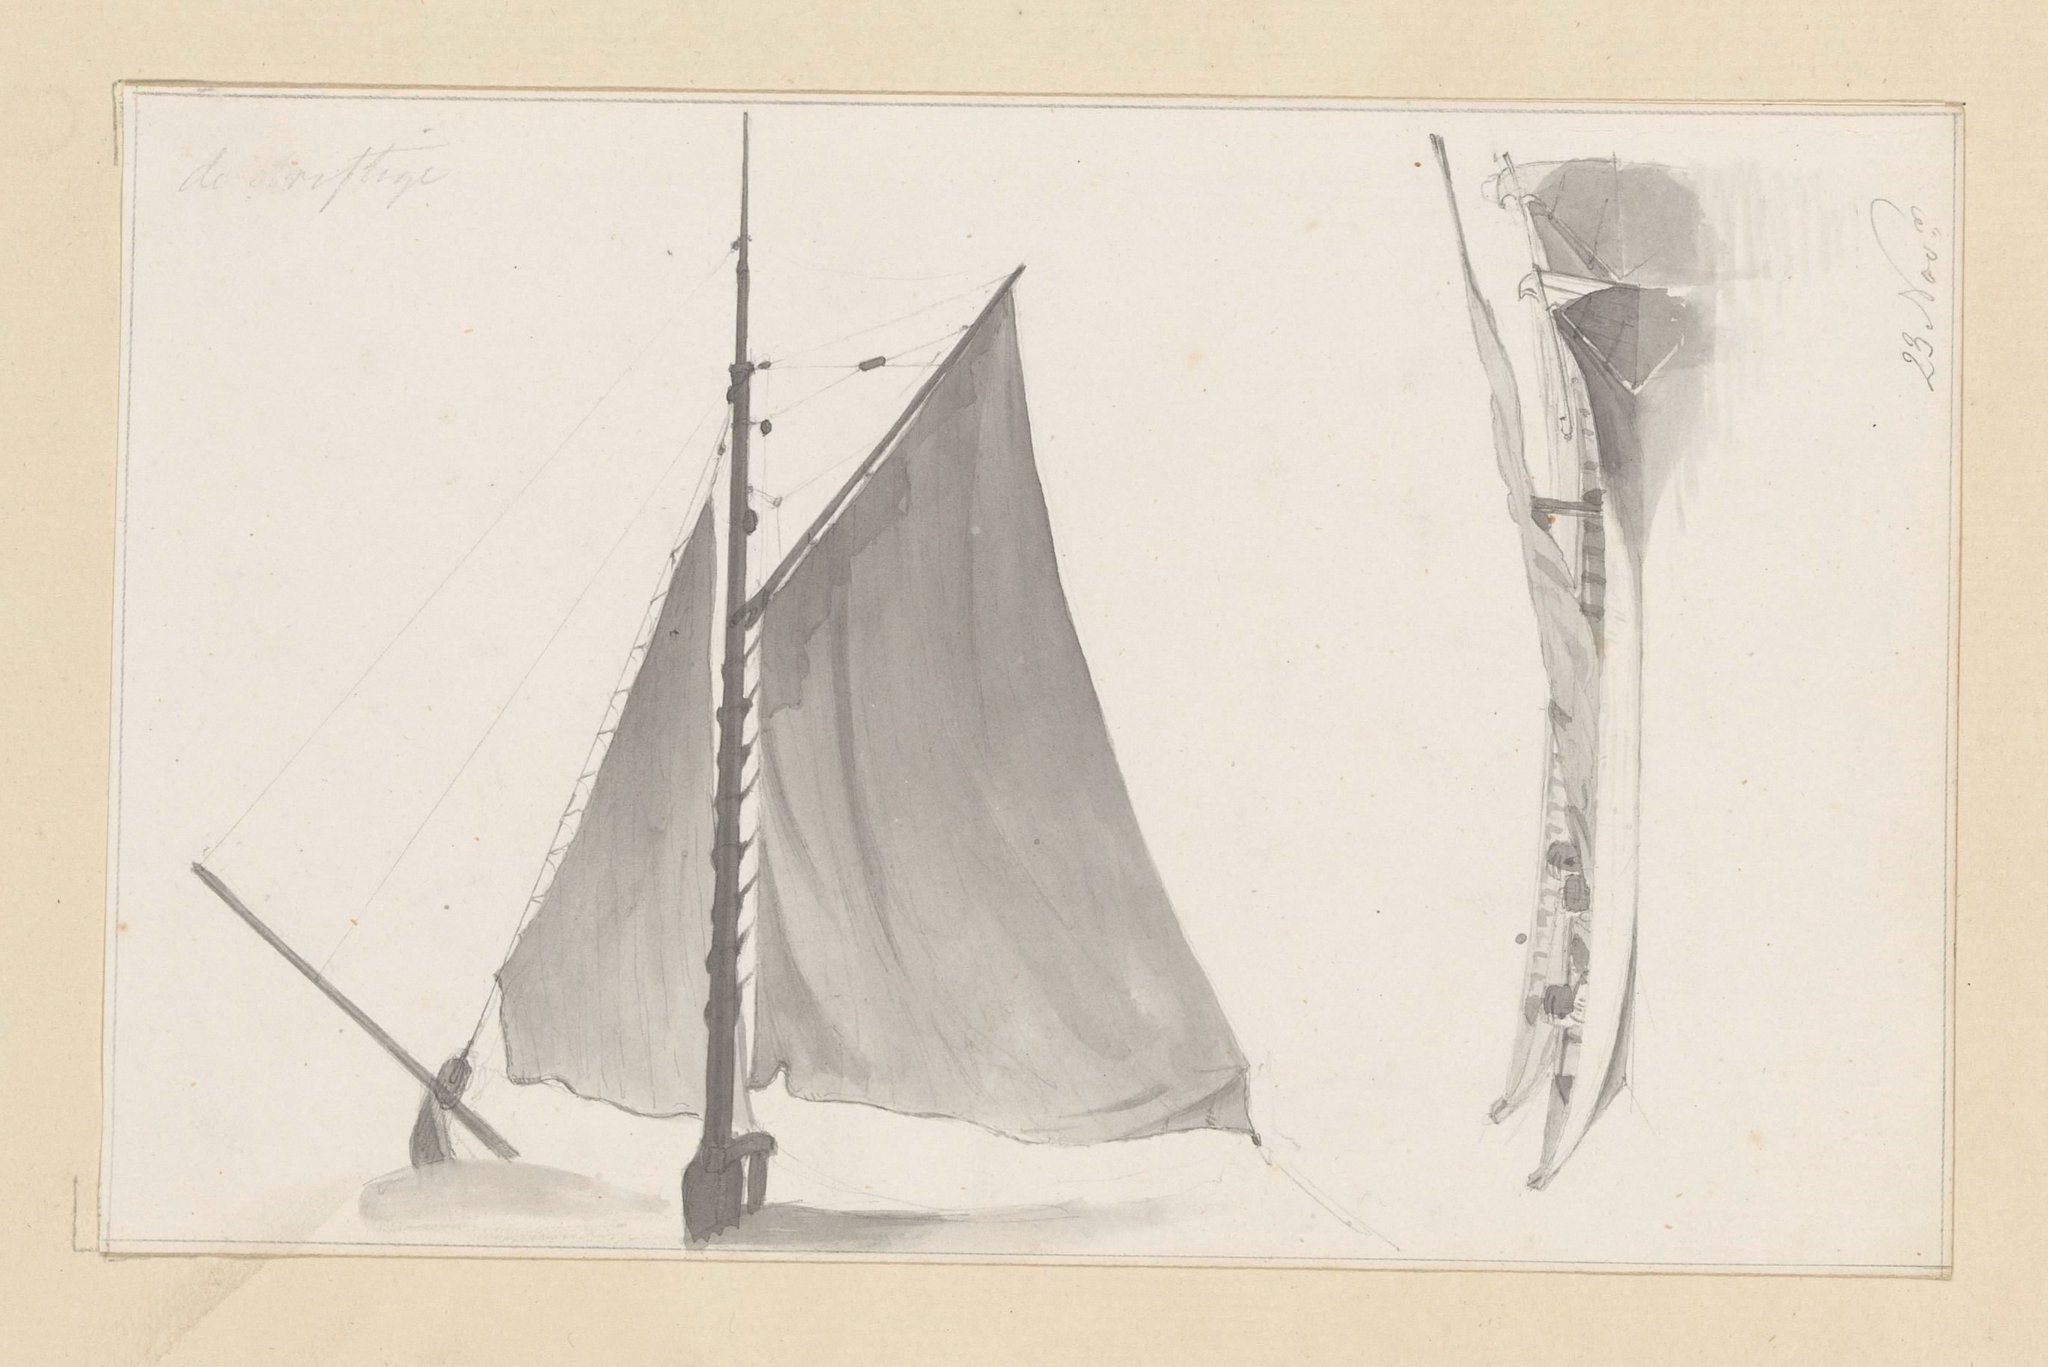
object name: drawing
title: Zeil van een boot en twee liggende boten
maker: hendrik abraham klinkhamer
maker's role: draughtsman, painter, print maker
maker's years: 1810-1872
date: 1820-1872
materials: paper, pencil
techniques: brush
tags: sailing-ship, sailing-boat, parts of sailing-ship's rigging